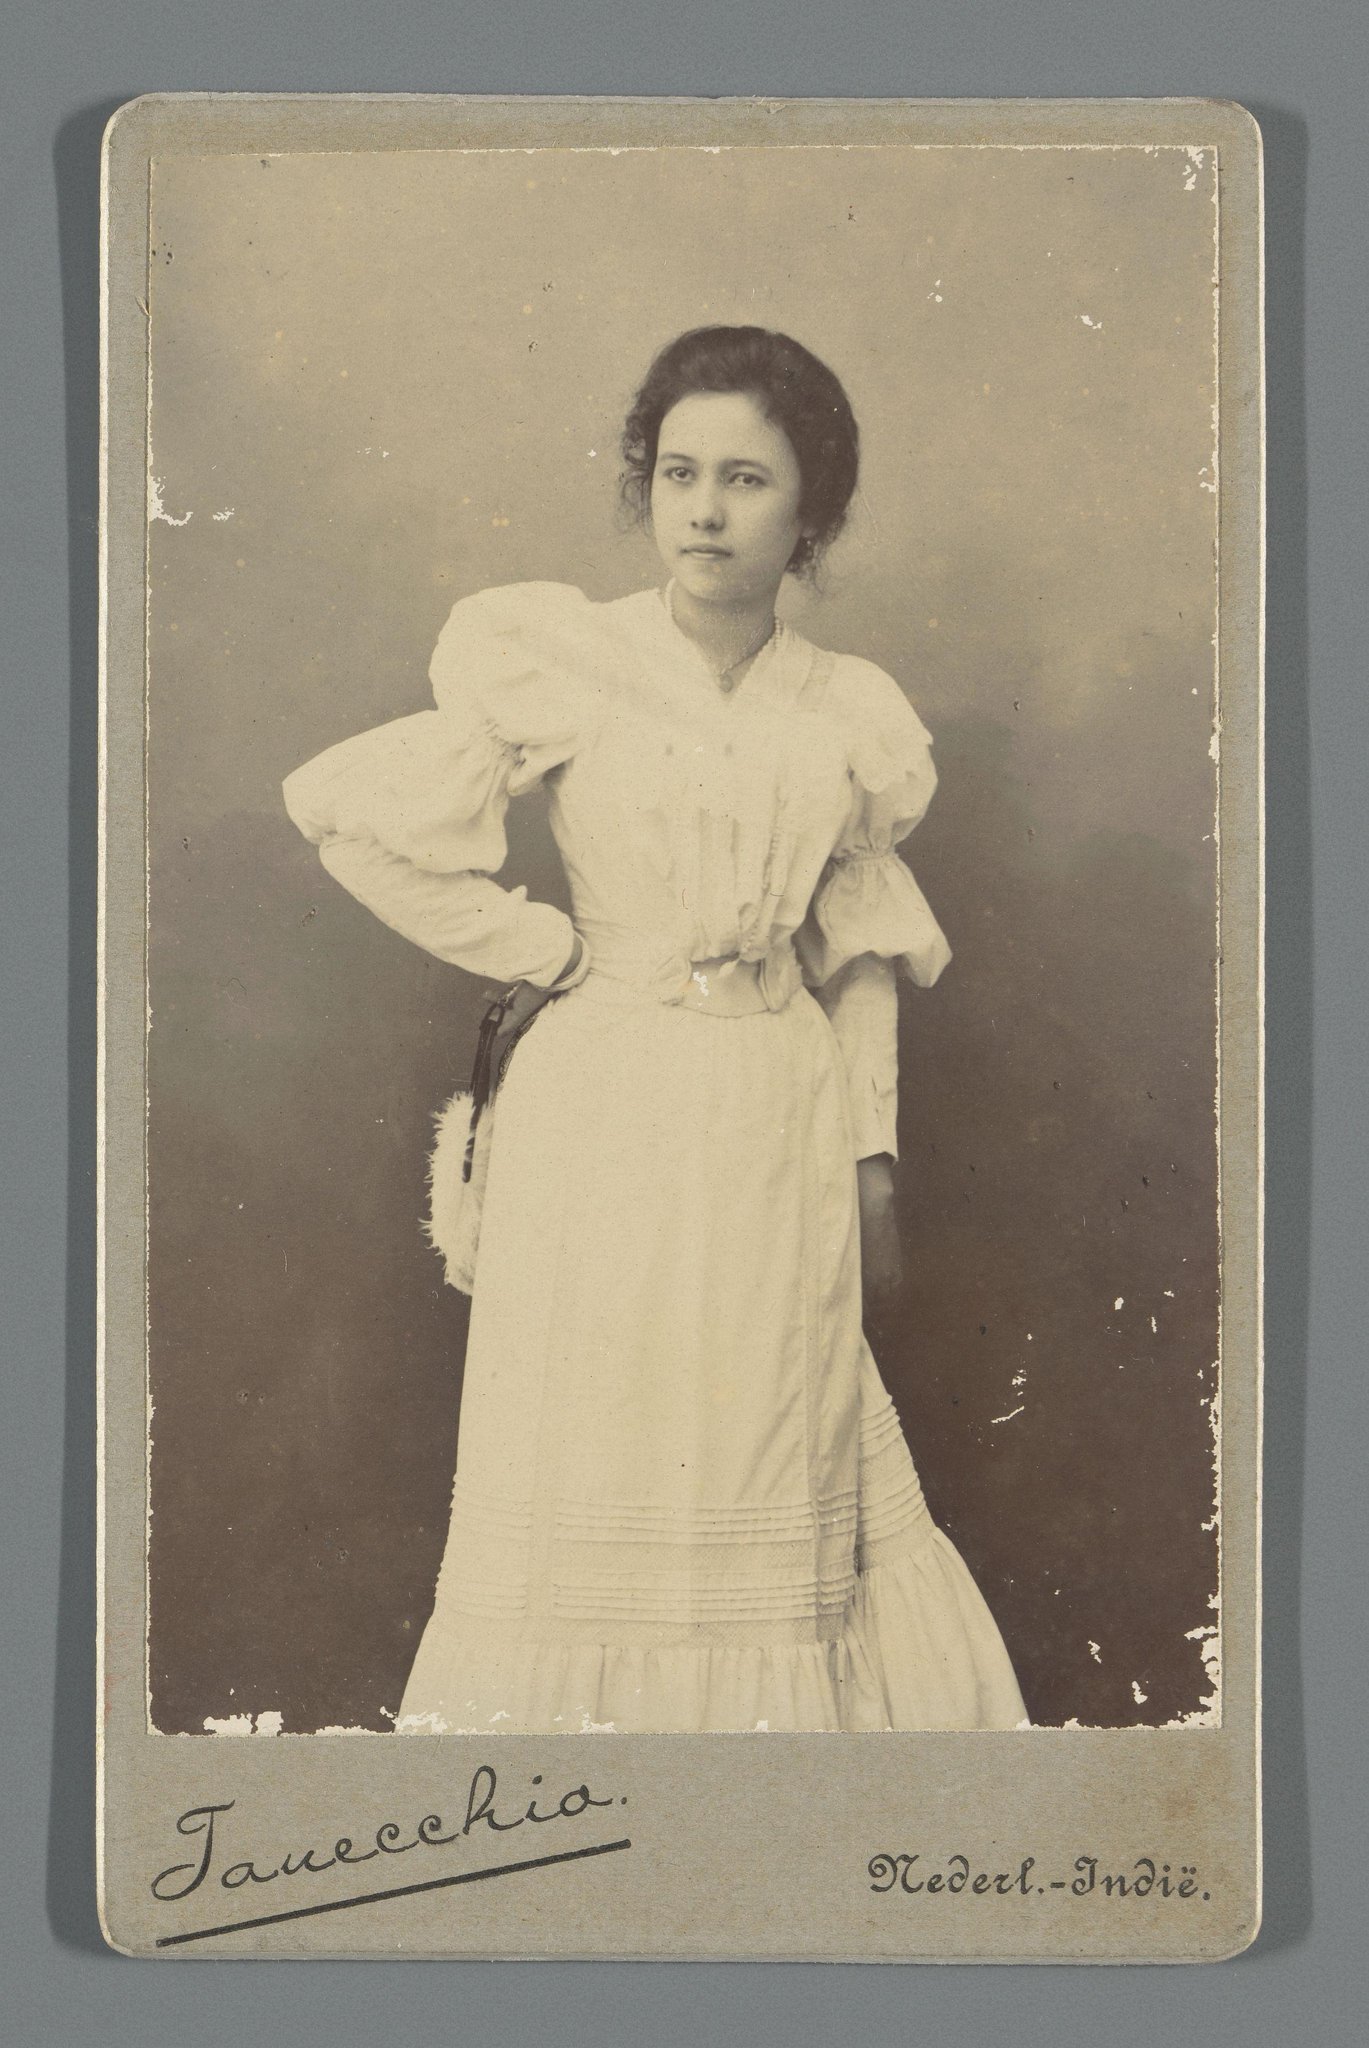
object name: photograph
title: Portret van Guusje Bruins als jonge vrouw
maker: tanecchia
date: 1895-1900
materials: cardboard, photographic support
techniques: collodion silver print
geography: dutch east indies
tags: java, adolescent, young woman, maiden, historical persons - bb - woman, dutch east indies, the